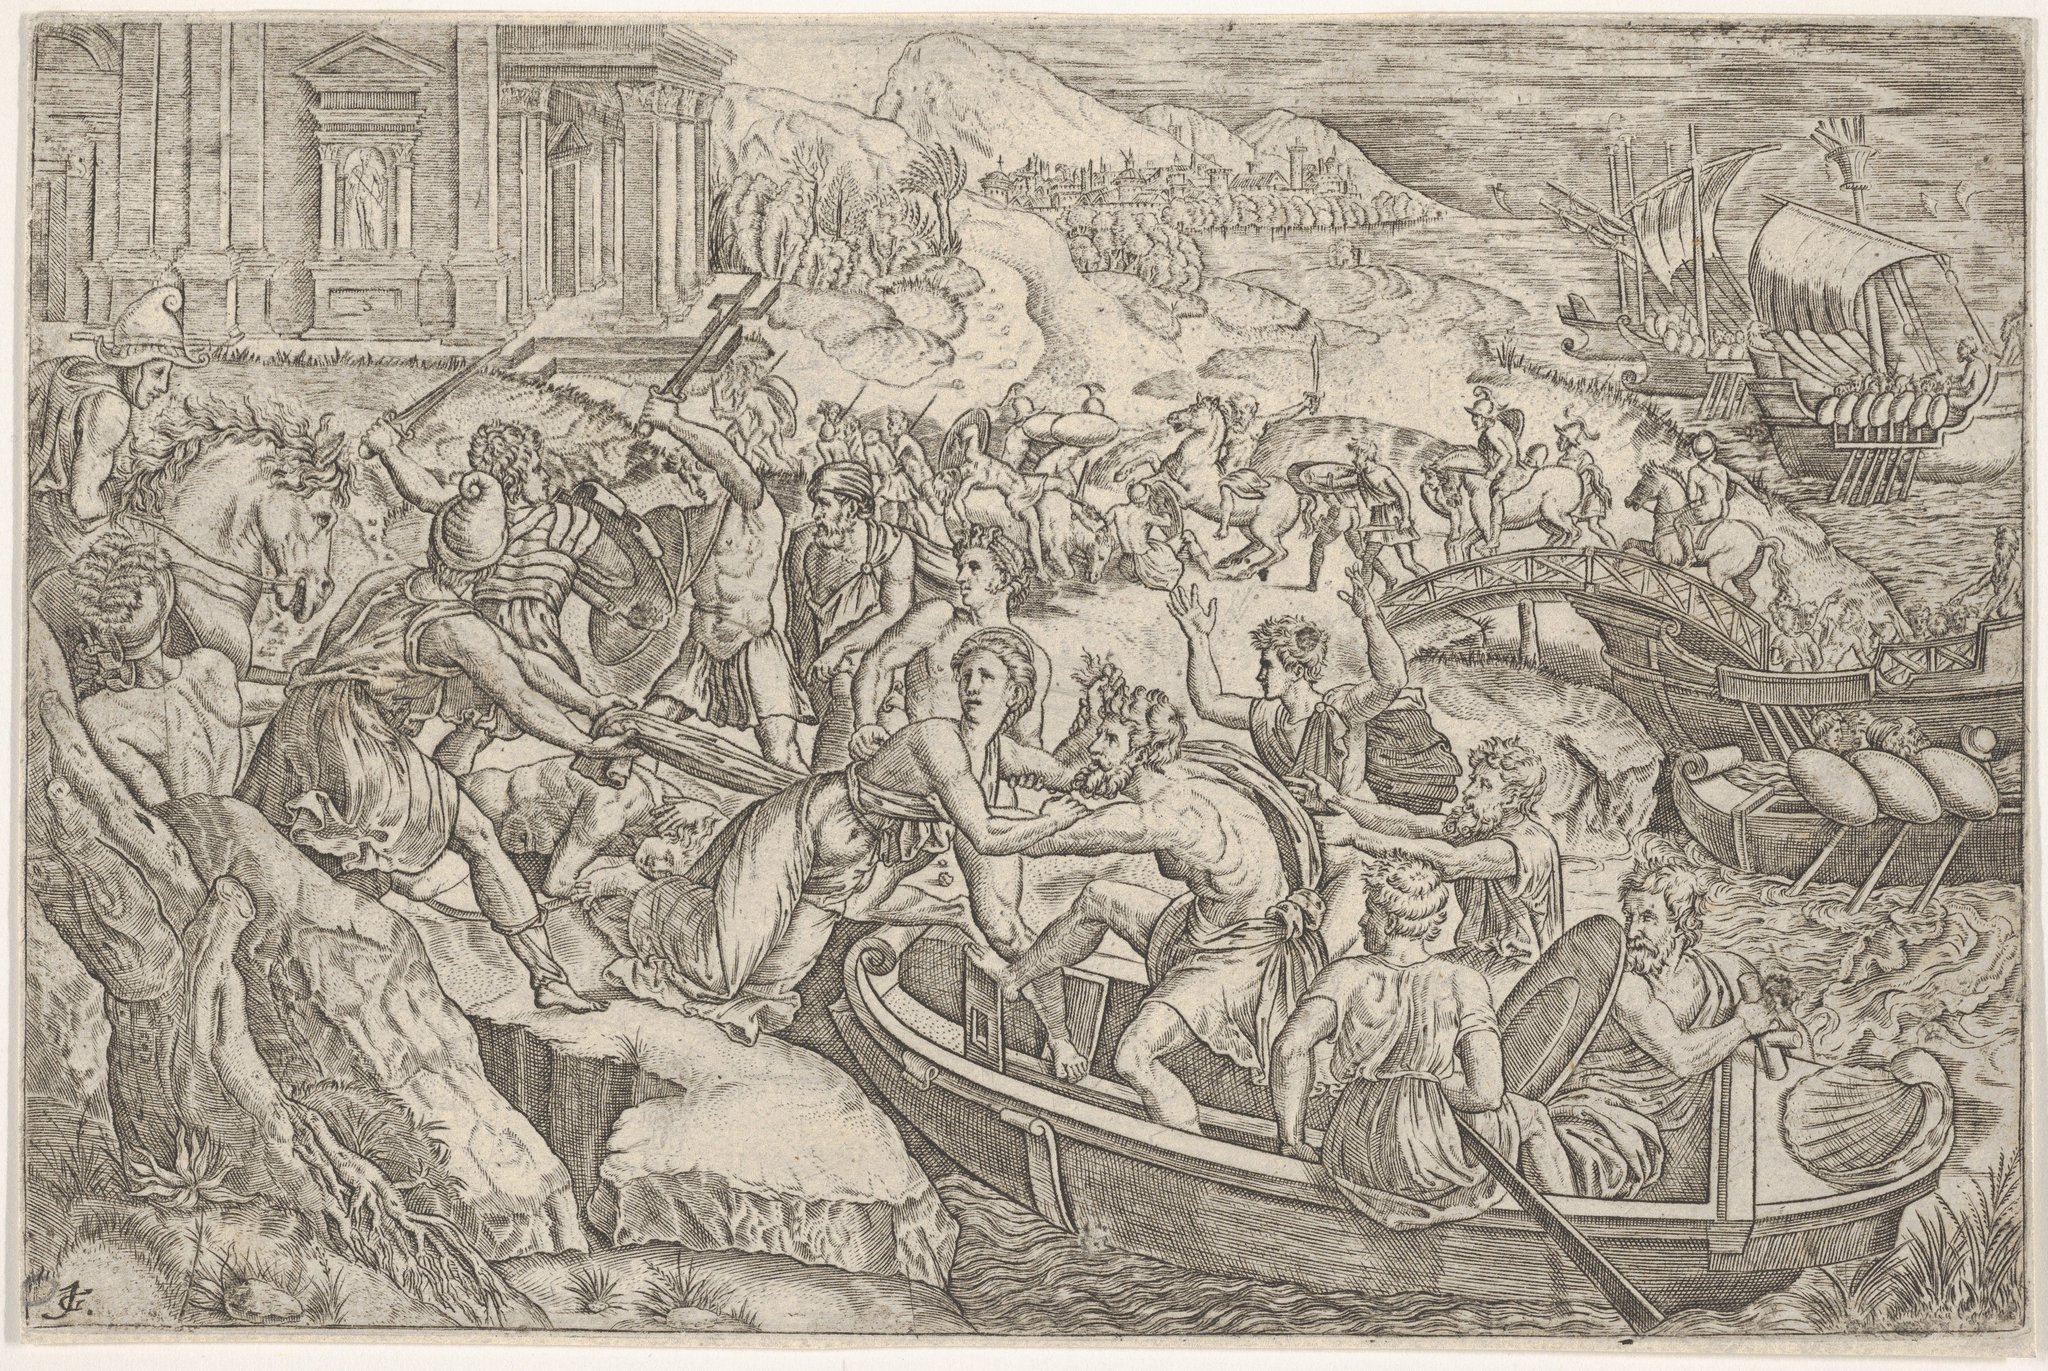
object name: print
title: Abduction of Helen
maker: anonymous, french, 16th century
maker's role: artist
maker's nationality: french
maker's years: 1500-1600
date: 1500-1600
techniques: engraving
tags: soldiers,helen,horses,boats